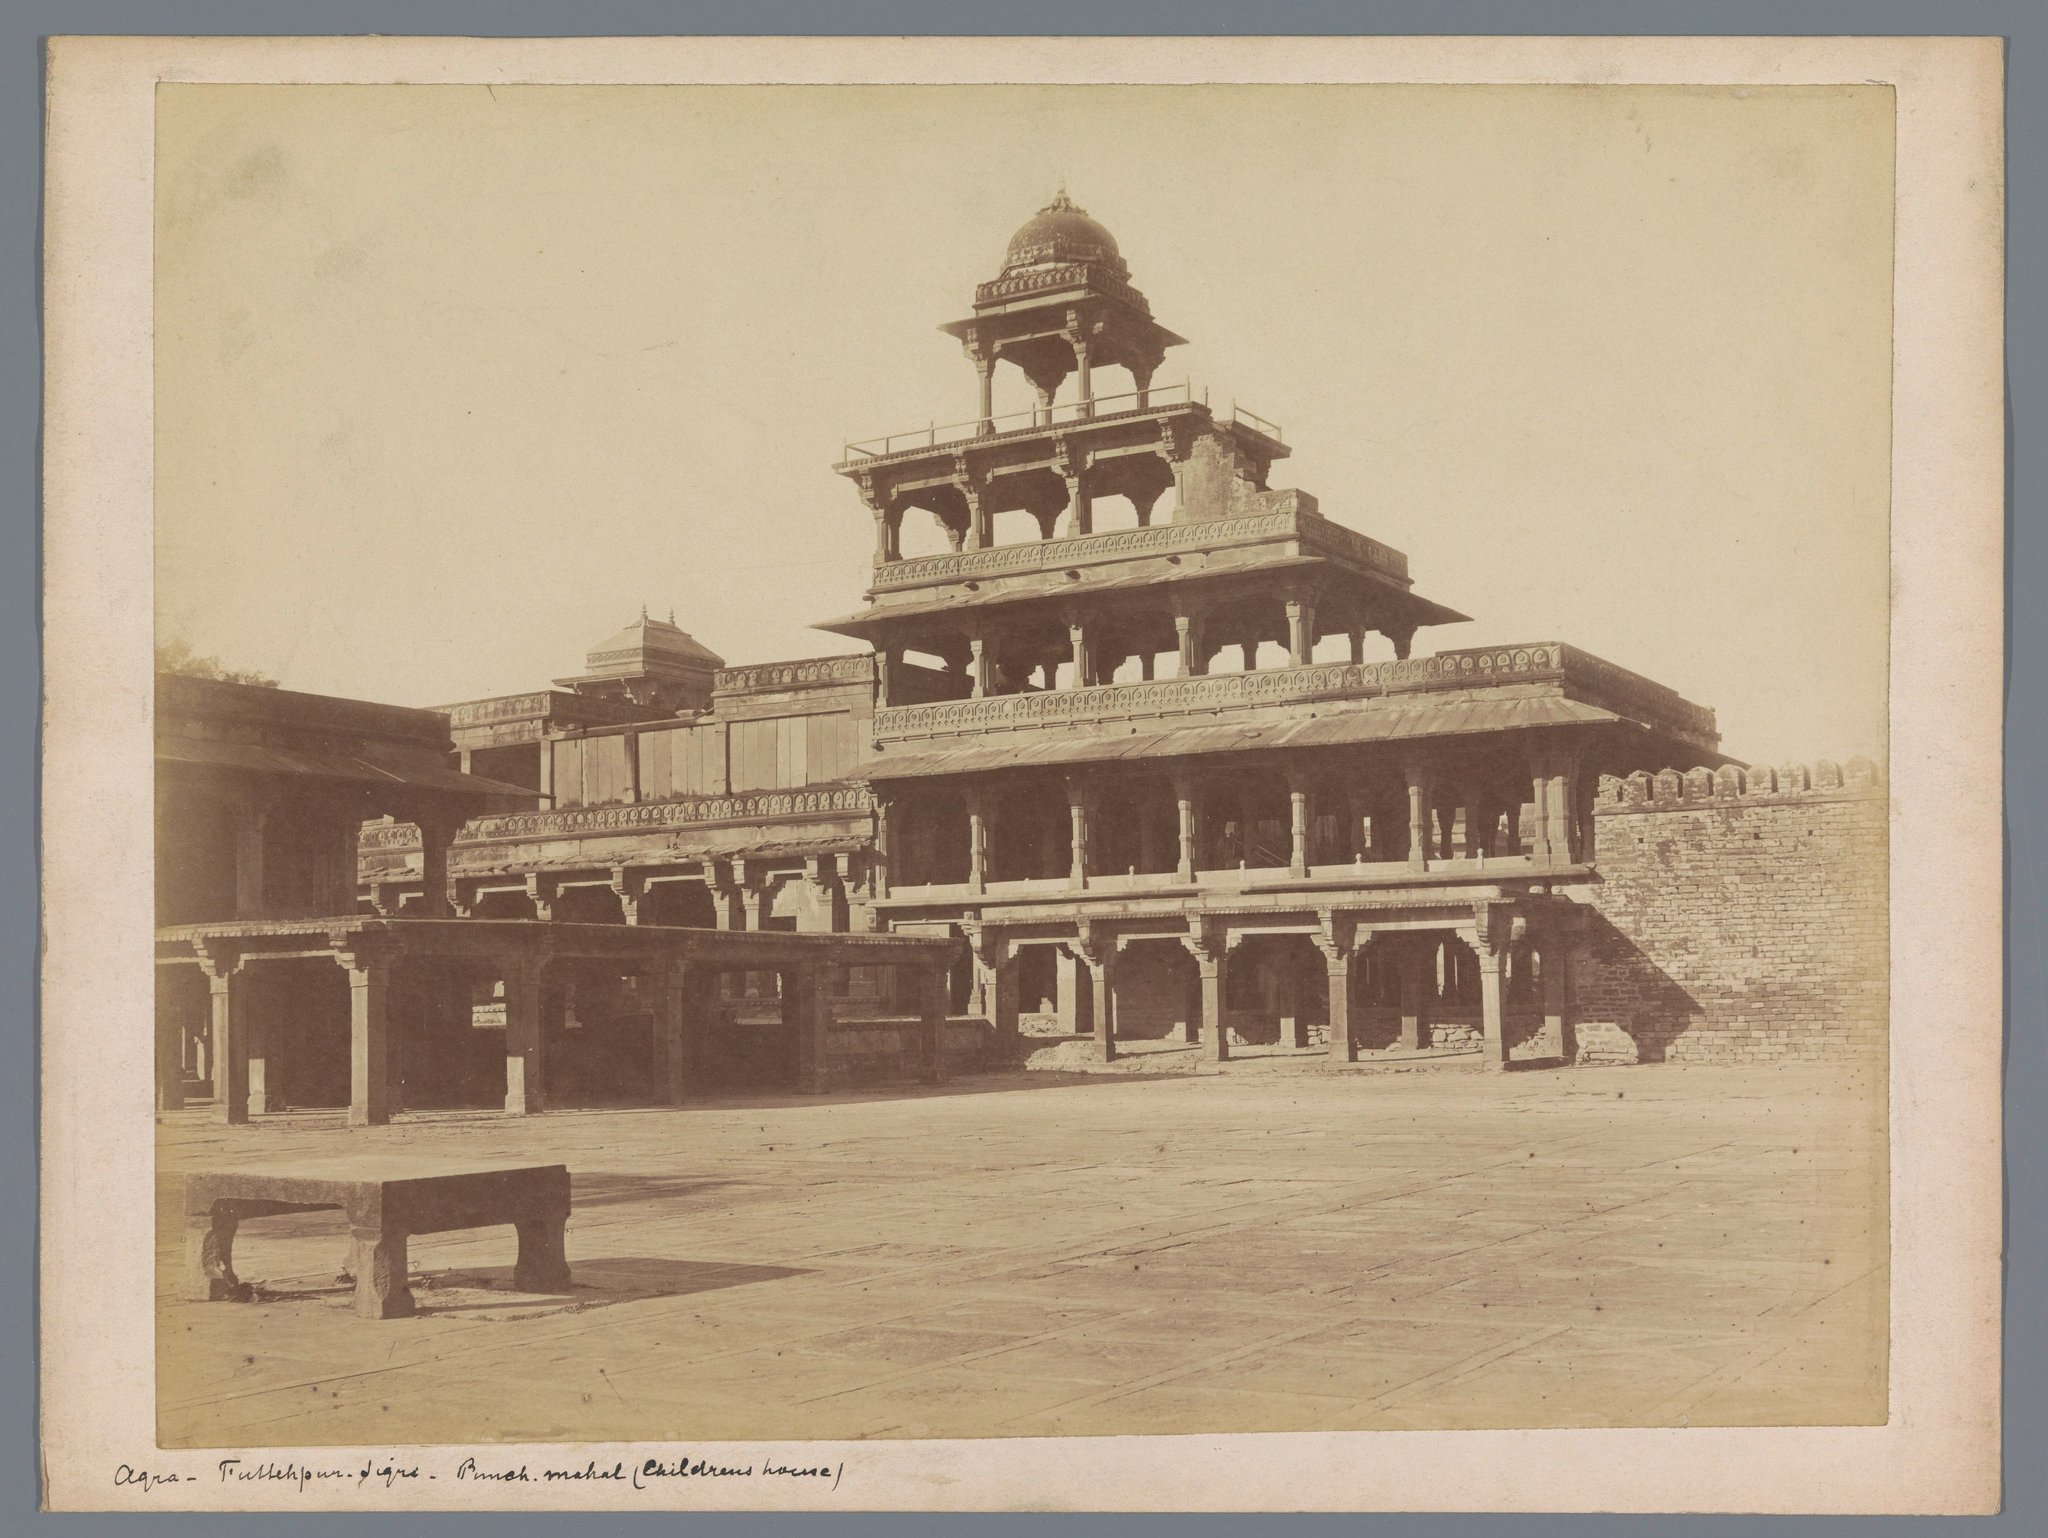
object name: photograph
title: View of the Panch Mahal at Fatehpur Sikri, Uttar Pradesh, India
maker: samuel bourne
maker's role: fotograaf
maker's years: 1834-1912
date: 1863-1870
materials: cardboard, paper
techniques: albumen print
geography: fatehpur sikri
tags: palace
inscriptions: title: ‘Agra - Futtehpur-Siqri - Punch. mahal (Childrens house)’, number: ‘55’